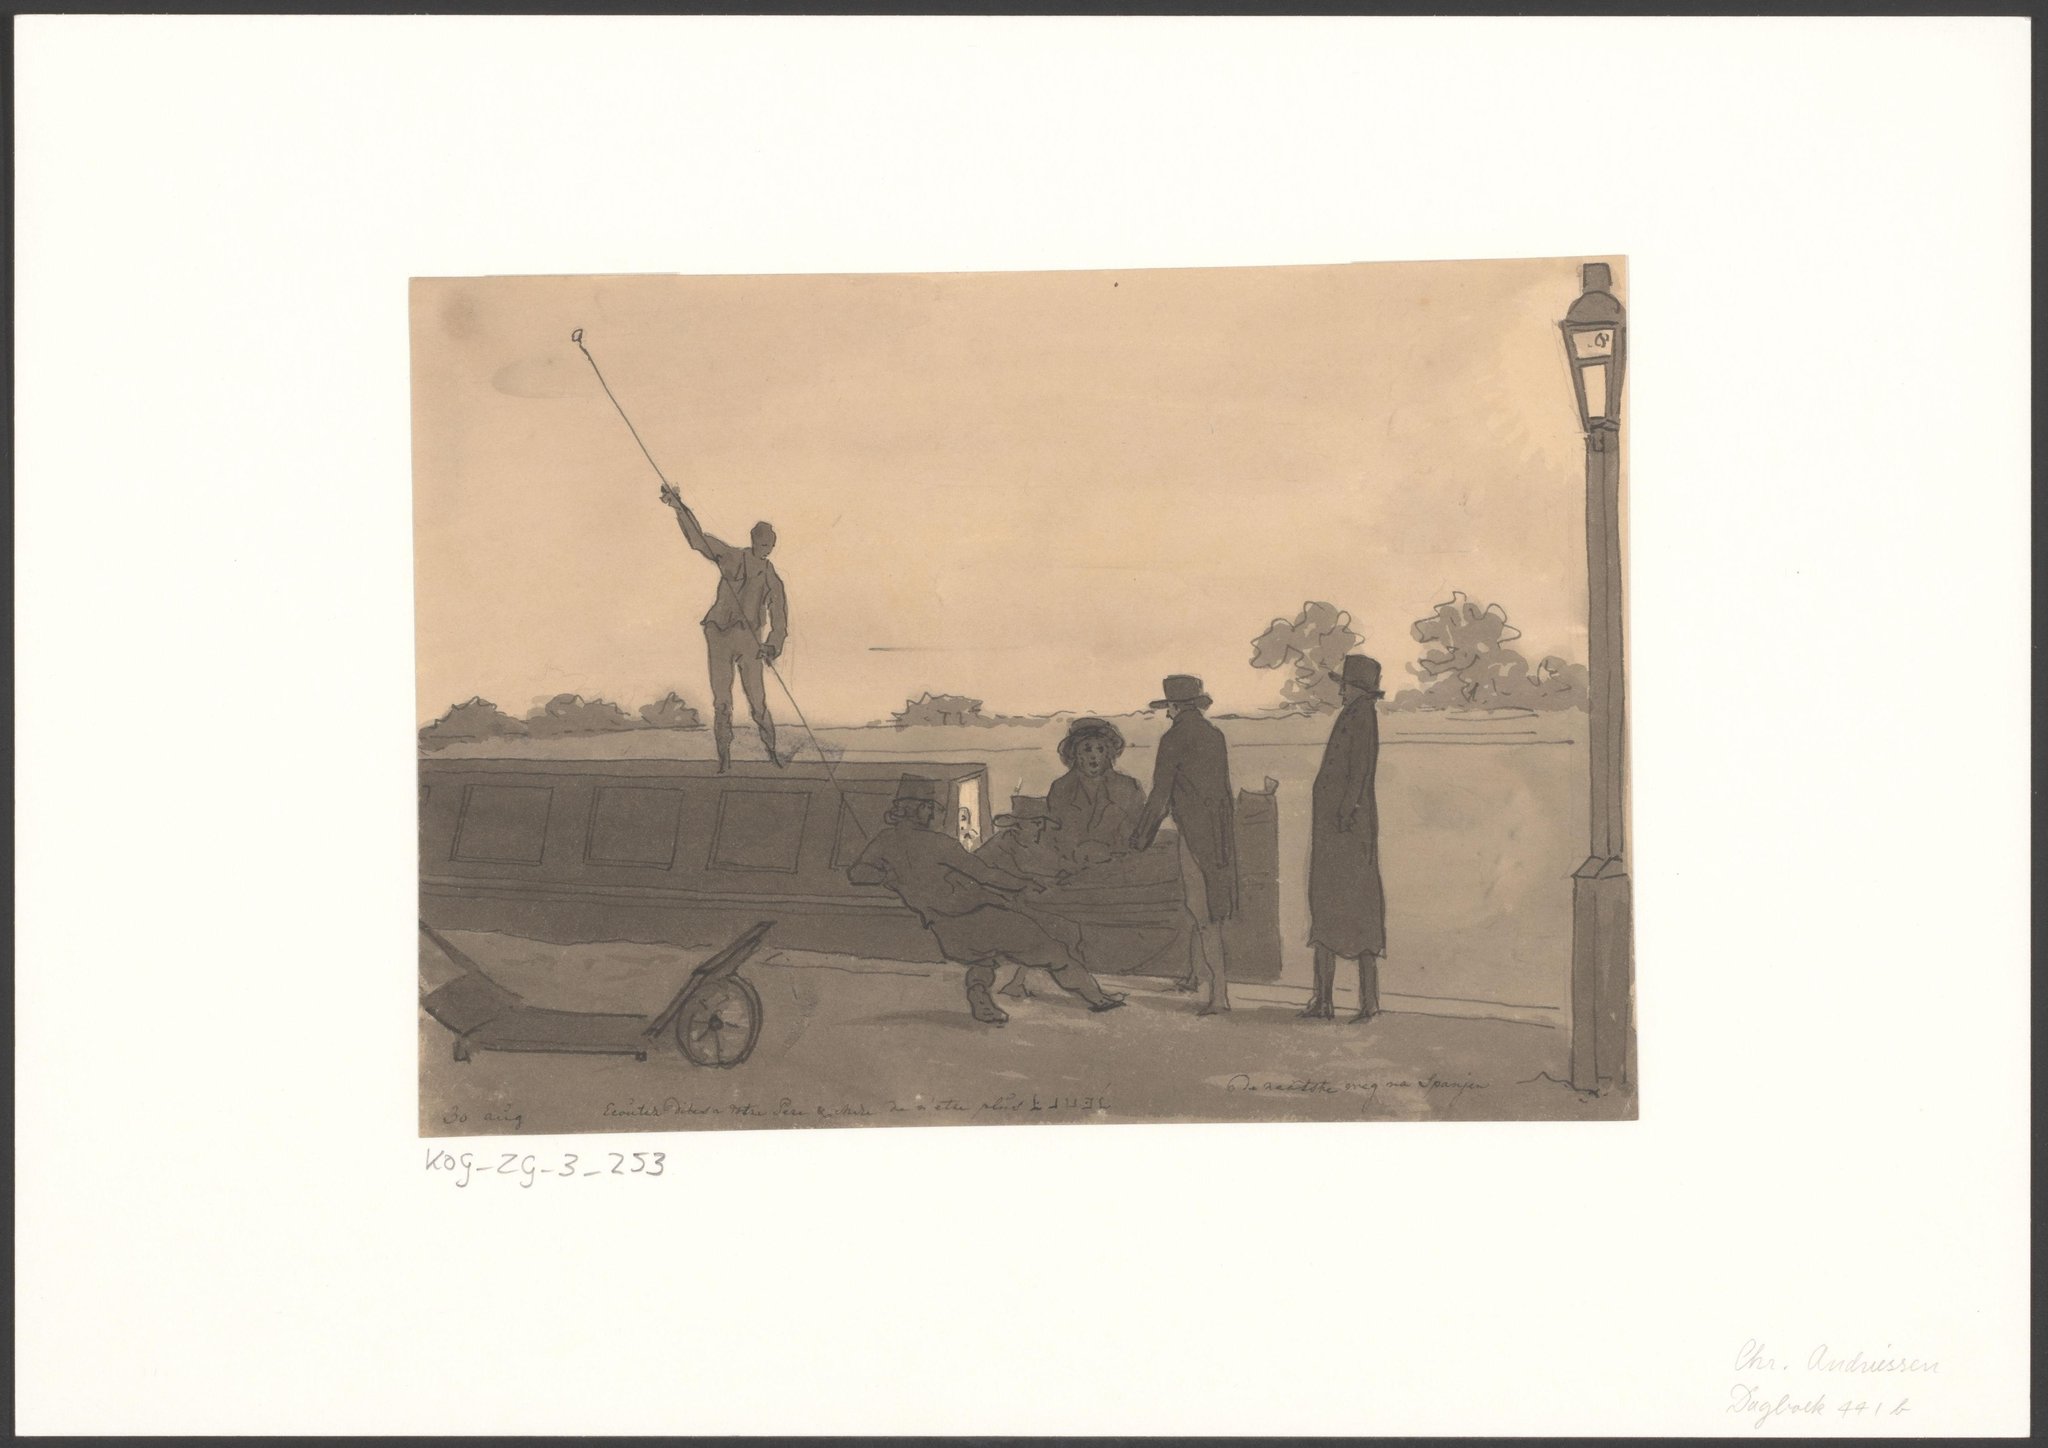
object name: drawing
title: Aanlegplaats van de Weesper trekschuit aan de Weesperzijde bij de IJsbreker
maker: christiaan andriessen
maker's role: draughtsman, print maker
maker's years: 1775-1846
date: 1805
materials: ink, paper, pencil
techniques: brush, pen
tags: amsterdam, print maker, draughtsman, christiaan andriessen, tow-boat, towing-barge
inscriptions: signature: ‘J Andriessen’, inscription: ‘30 aug. Ecoutez dites a votre Pere & Mere de n'etre plus faché’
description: Dagboekblad uit het getekende dagboek dat Christiaan Andriessen bijhield van 1805 tot en met 1808.